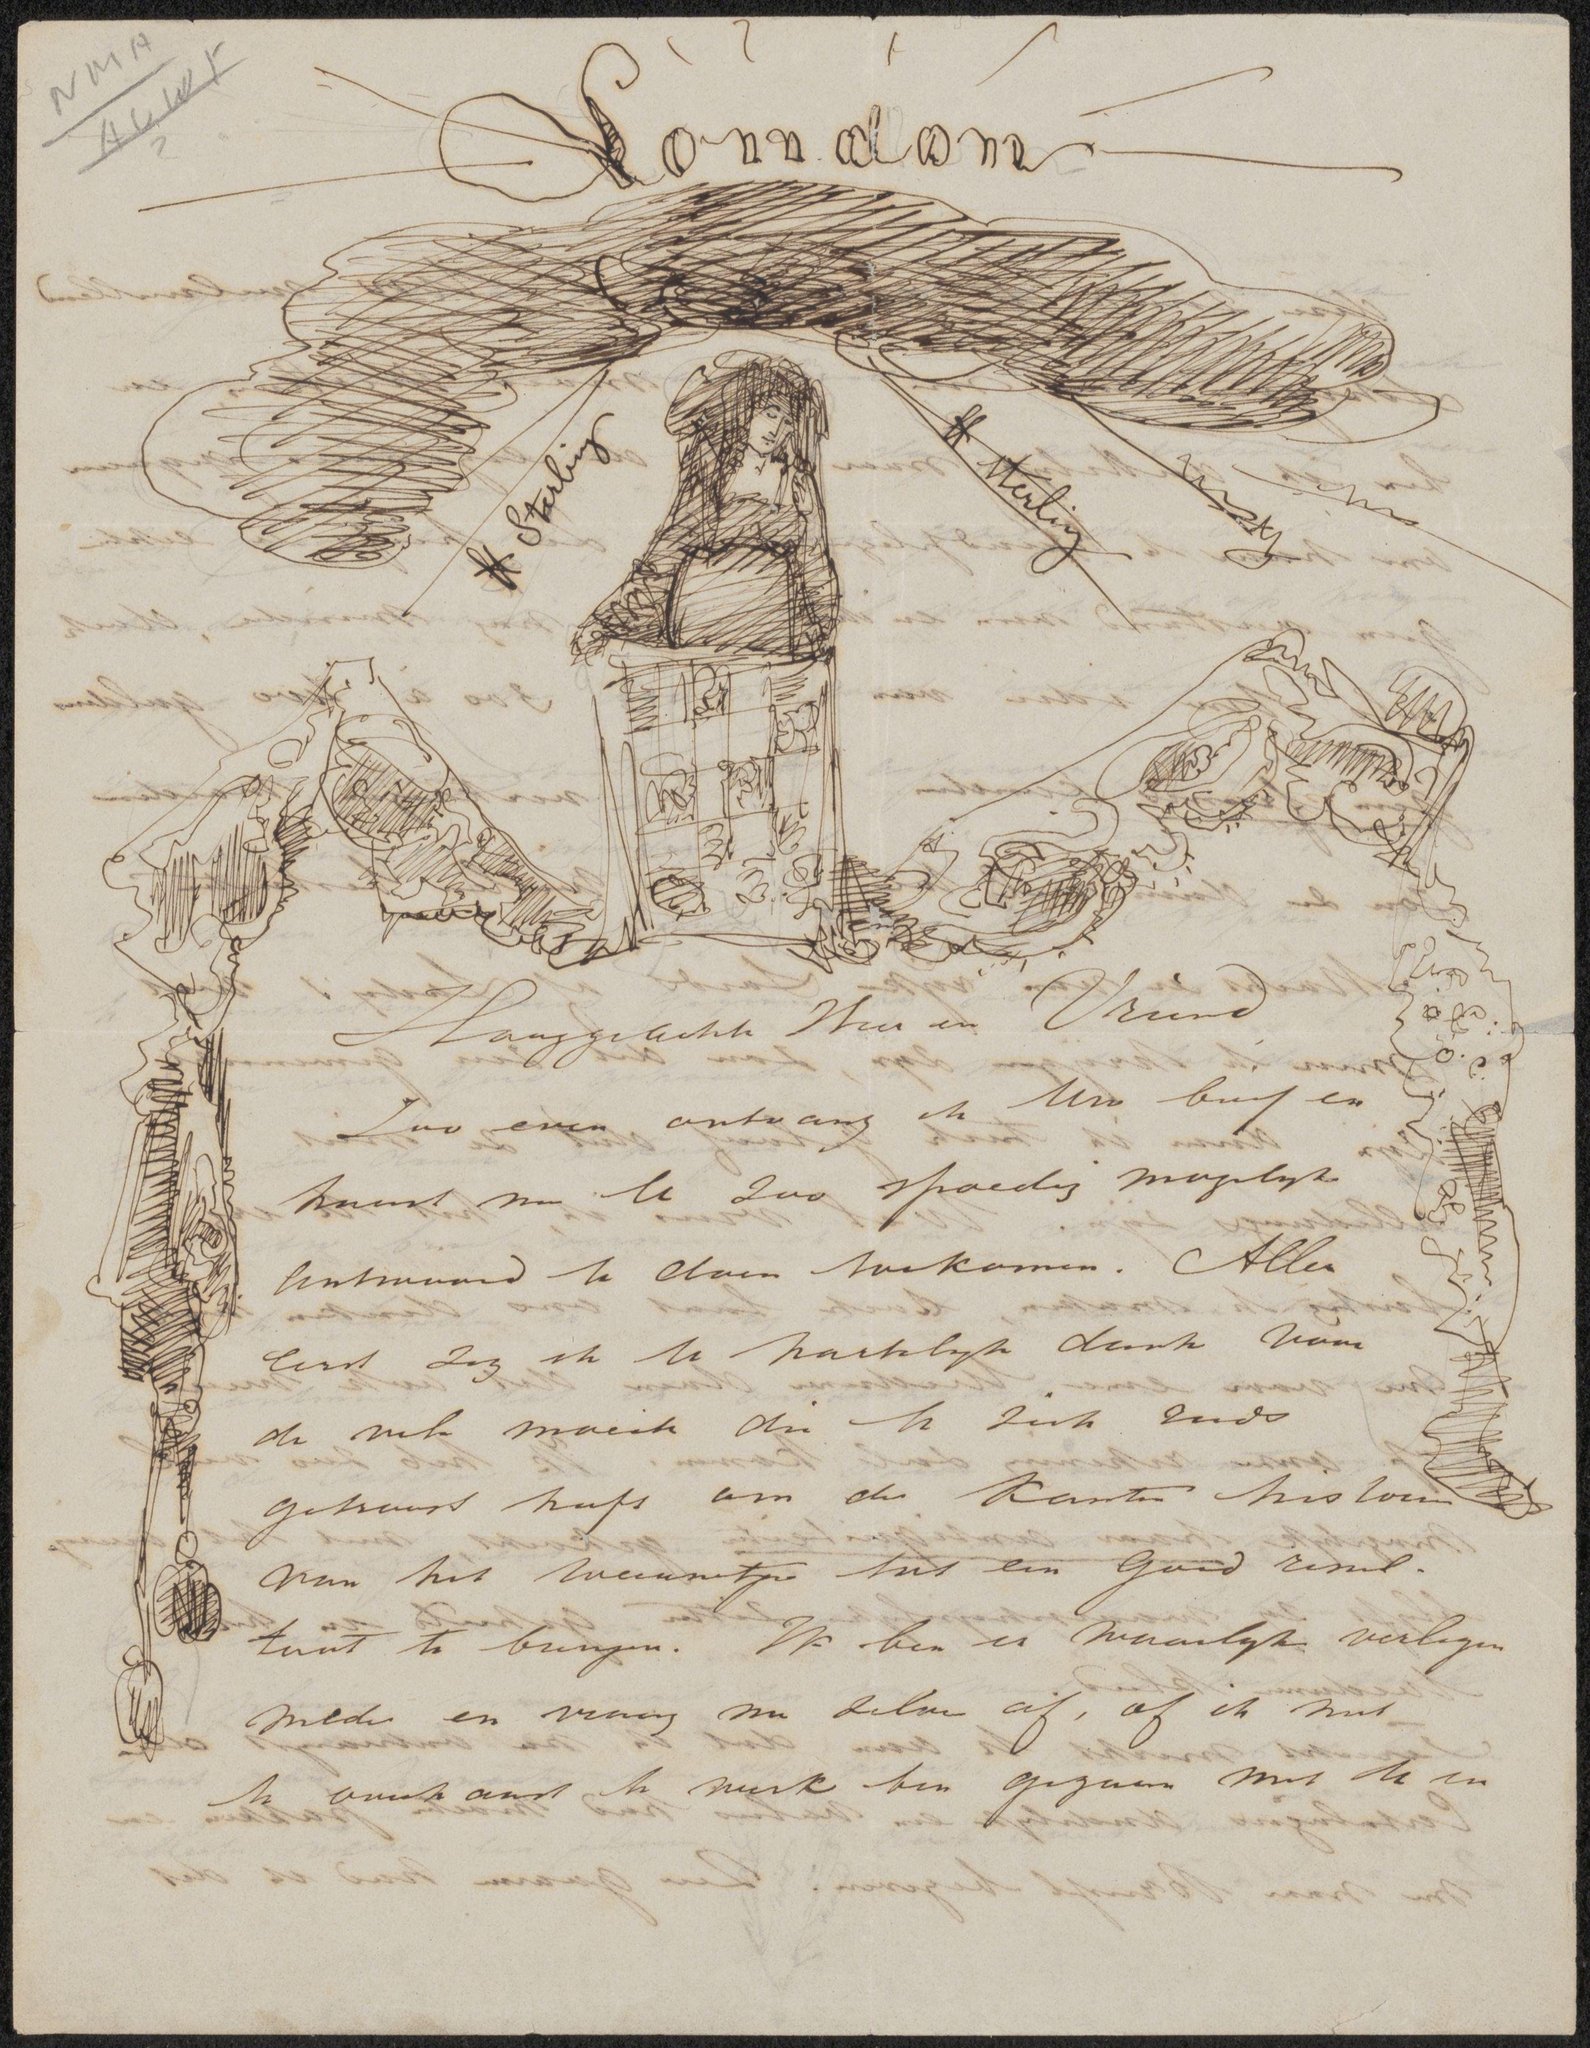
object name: letter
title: Brief aan anoniem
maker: alexander hugo bakker korff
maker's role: draughtsman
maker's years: 1824-1882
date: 1873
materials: ink, paper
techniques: pen, writing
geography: leiden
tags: publisher, standing figure - aa - female human figure, painting (including book-illumination, miniature-painting), money, printed matter, london, brussels